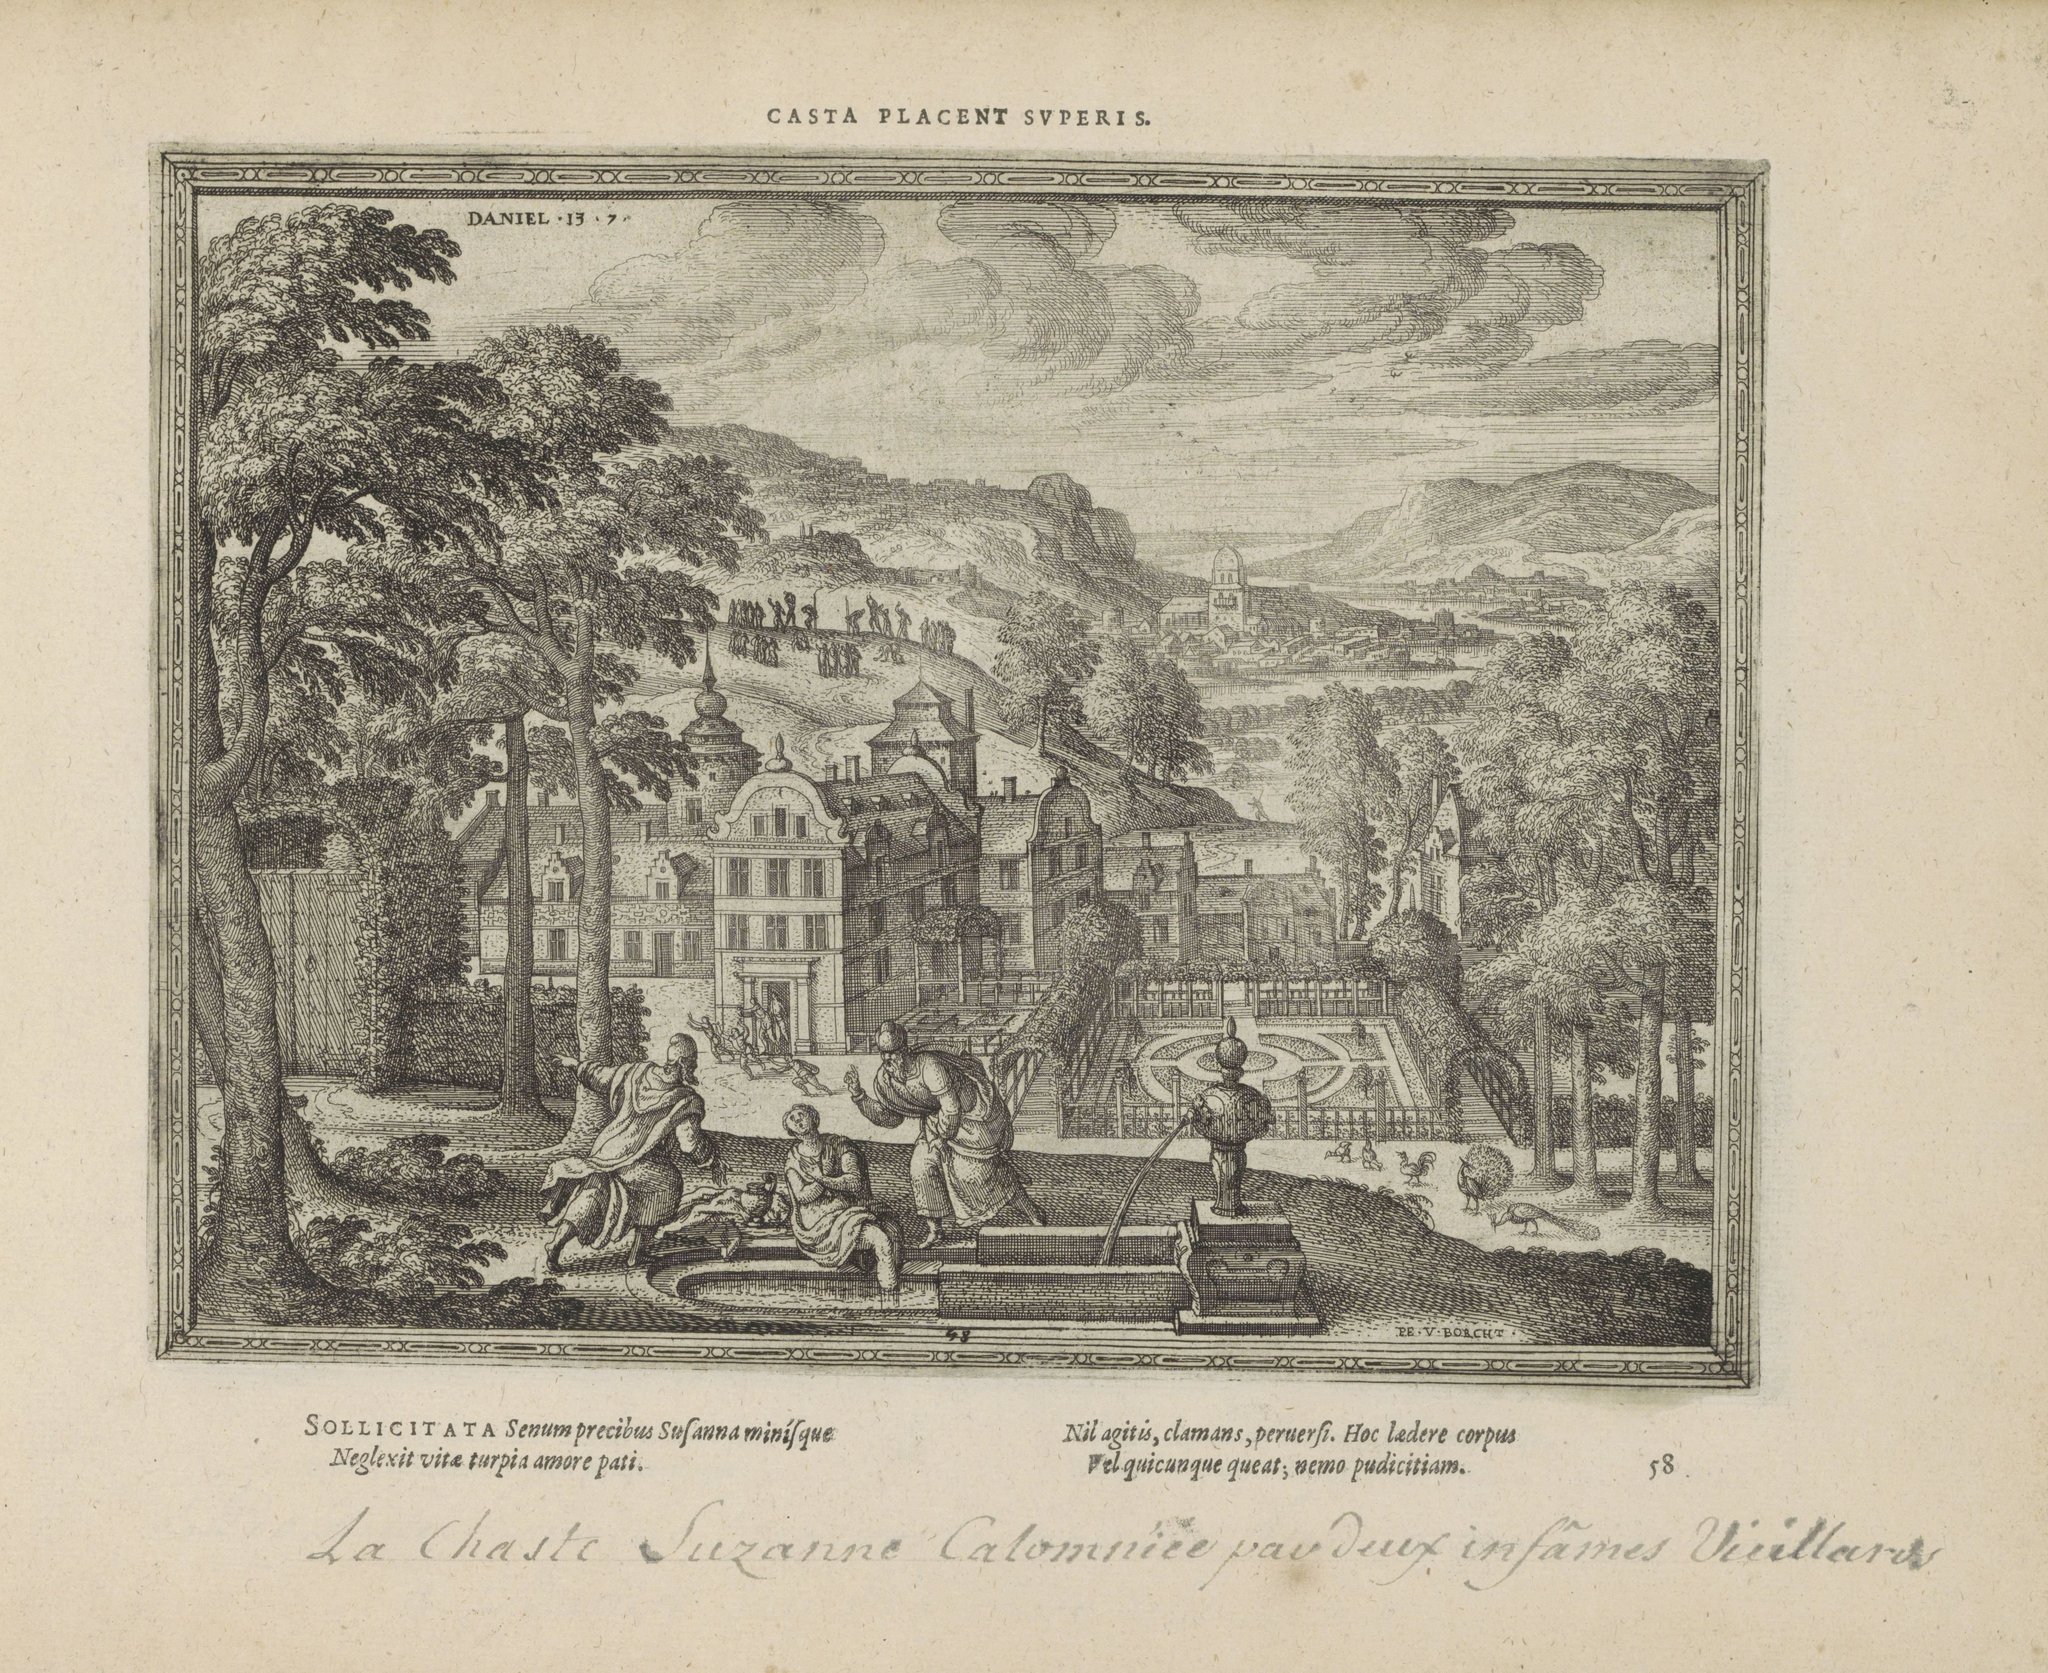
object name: print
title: Casta placent superis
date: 1582-1593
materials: paper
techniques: etching, letterpress printing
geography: antwerp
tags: the elders making advances towards susanna, susanna bathing, usually in or near a fountain and sometimes accompanied by two female servants, the elders are stoned to death ~ story of susanna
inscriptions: inscription: ‘La chaste Suzanne calomniee par deux infames vieillards’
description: Een hoftuin met Susanna en de ouderlingen. Susanna, badend bij een fontein in een tuin. De twee ouderlingen komen op haar af. Uit het huis in de achtergrond stromen de bewoners naar buiten om te zien wat er aan de hand is. Rechts twee pauwen, twee kippen en een haan. In de verte worden de twee ouderlingen ter dood gebracht (Dan. 13:7). Met een motto in het Latijn boven de voorstelling en een vierregelig onderschrift in het Latijn onder de prent. De prent maakt deel uit van een album.